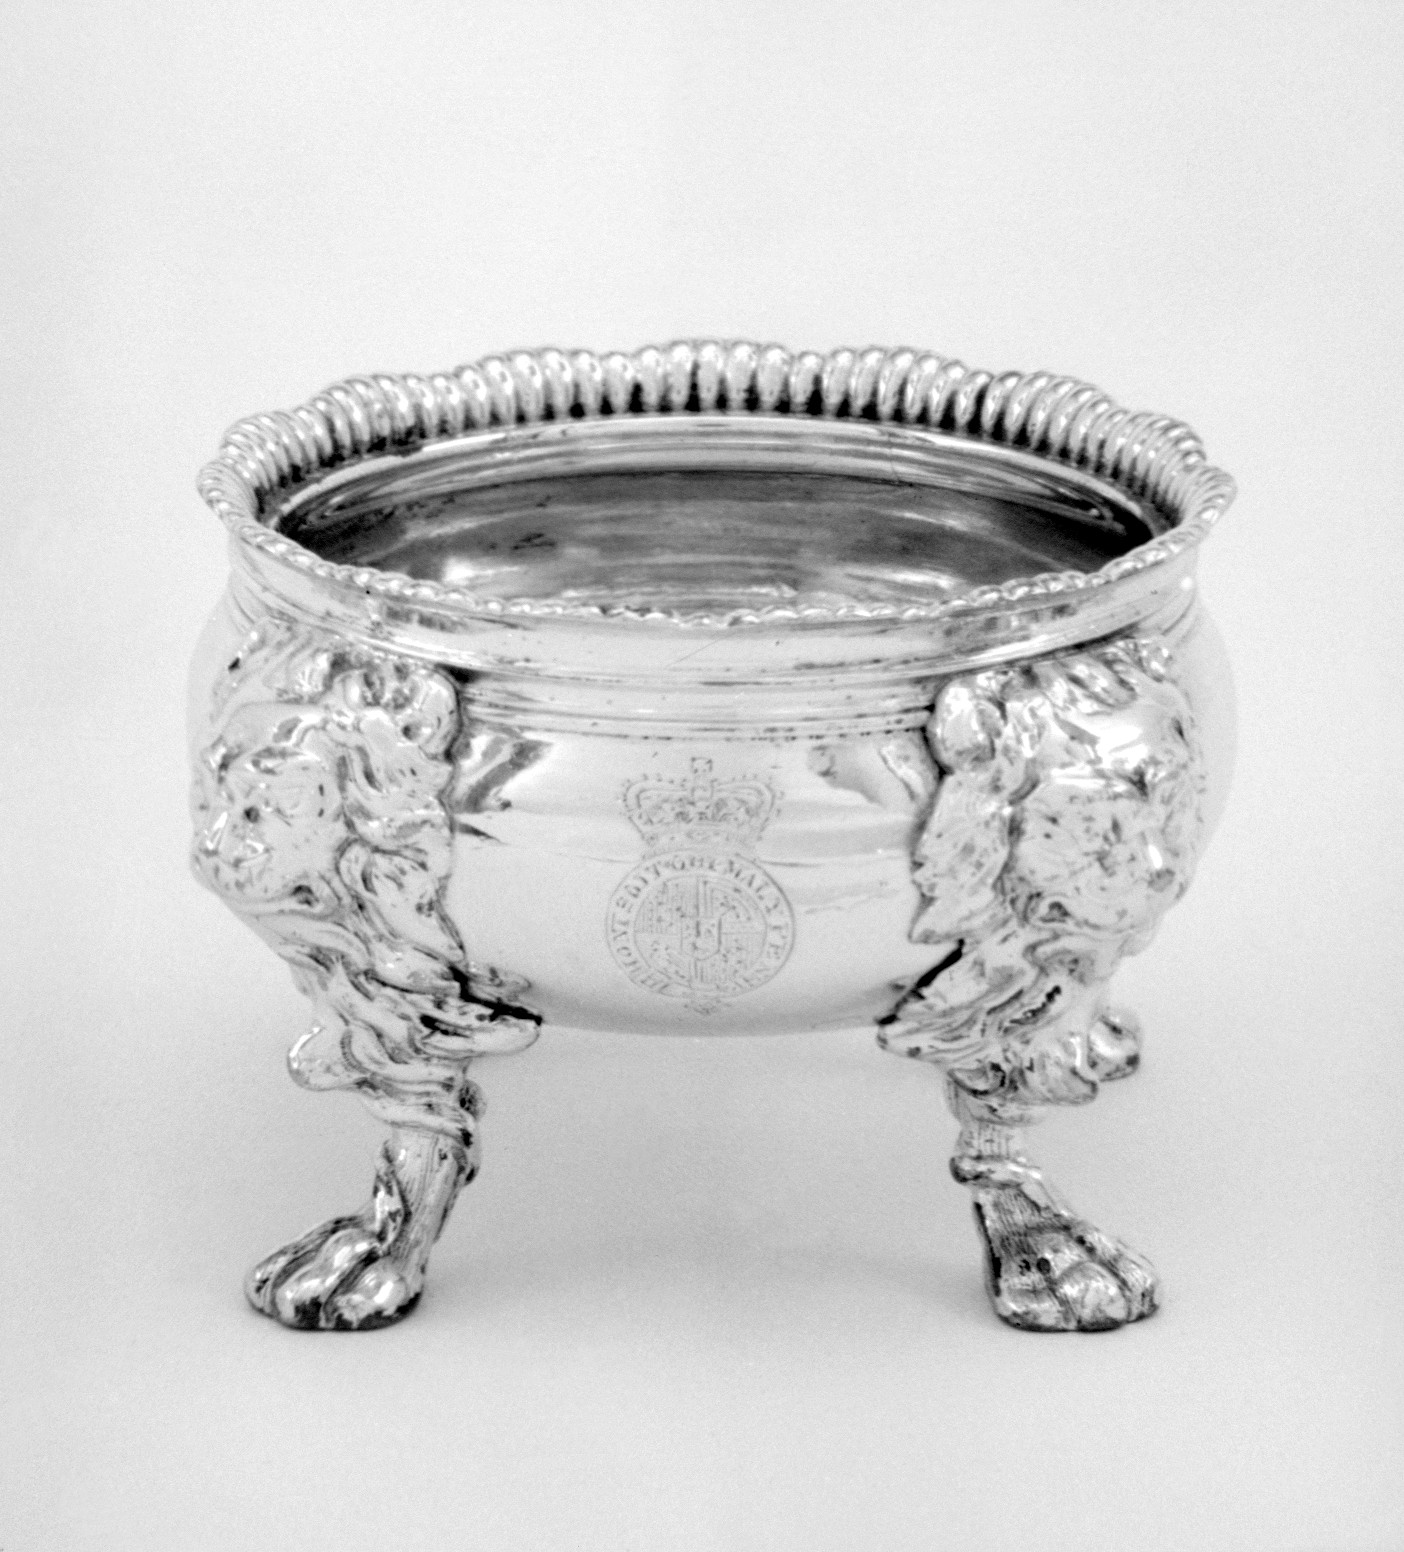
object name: saltcellar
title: Set of four saltcellars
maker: paul de lamerie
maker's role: maker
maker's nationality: british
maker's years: 1688-1751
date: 1735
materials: silver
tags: lions